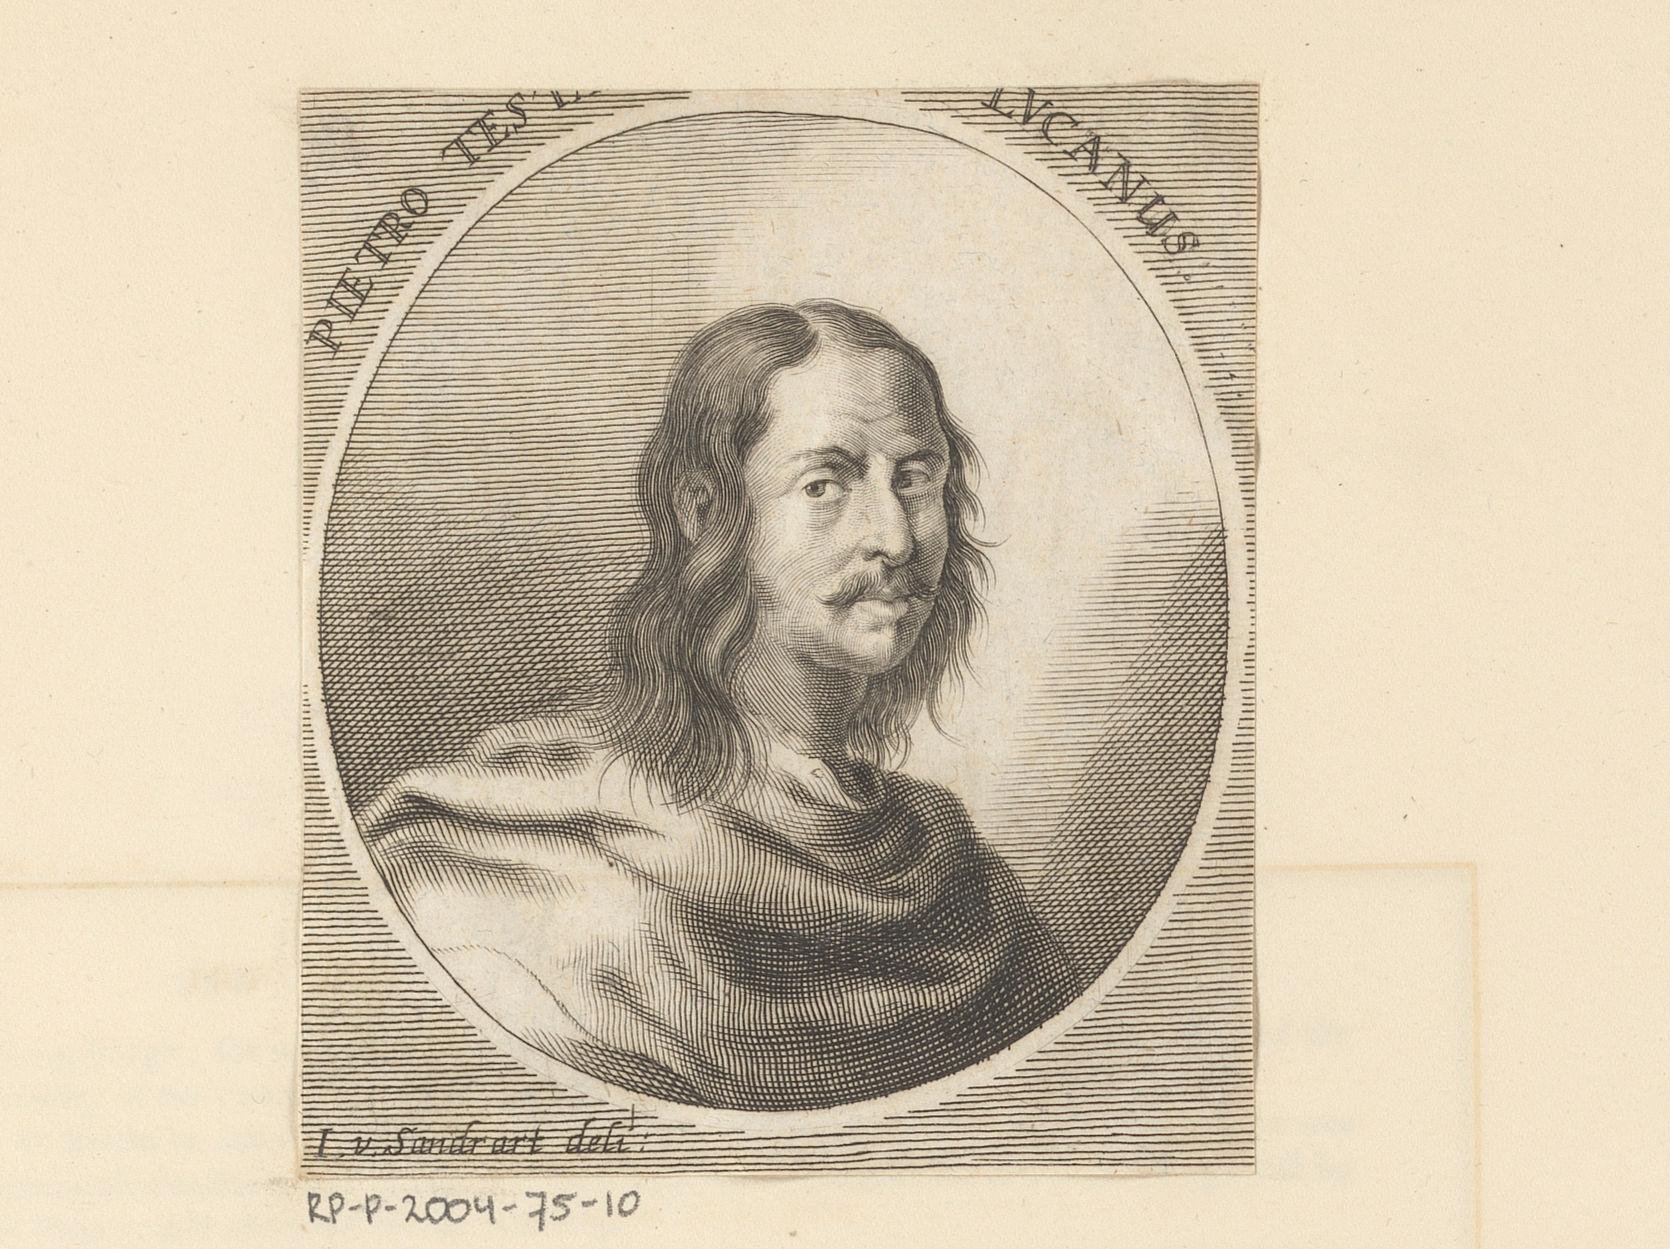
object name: print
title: Portret van Pietro Testa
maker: philipp kilian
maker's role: print maker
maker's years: 1628-1693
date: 1768-1775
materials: paper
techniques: engraving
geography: nuremberg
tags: rome, painter, print maker, draughtsman, pietro testa, historical persons, portrait, self-portrait of painter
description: Prent uit: Sandrart, Joachim von. Teutsche Academie der Bau- Bildhauer- und Maler-Kunst: worinn die Regeln und Lehrsätze dieser Künste gegeben. 14 dln. Neurenberg: erven Johann Andreas Endter, [1774], dl. 7, p. T. De samensteller heeft deze prent in het album geplakt als illustratie bij: Pilkington, Matthew en Johann Heinrich Füssli. A dictionary of painters, from the revival of the art to the present period. 4 dln. Londen: John Crowder, 1805, dl. 4, p. 555.